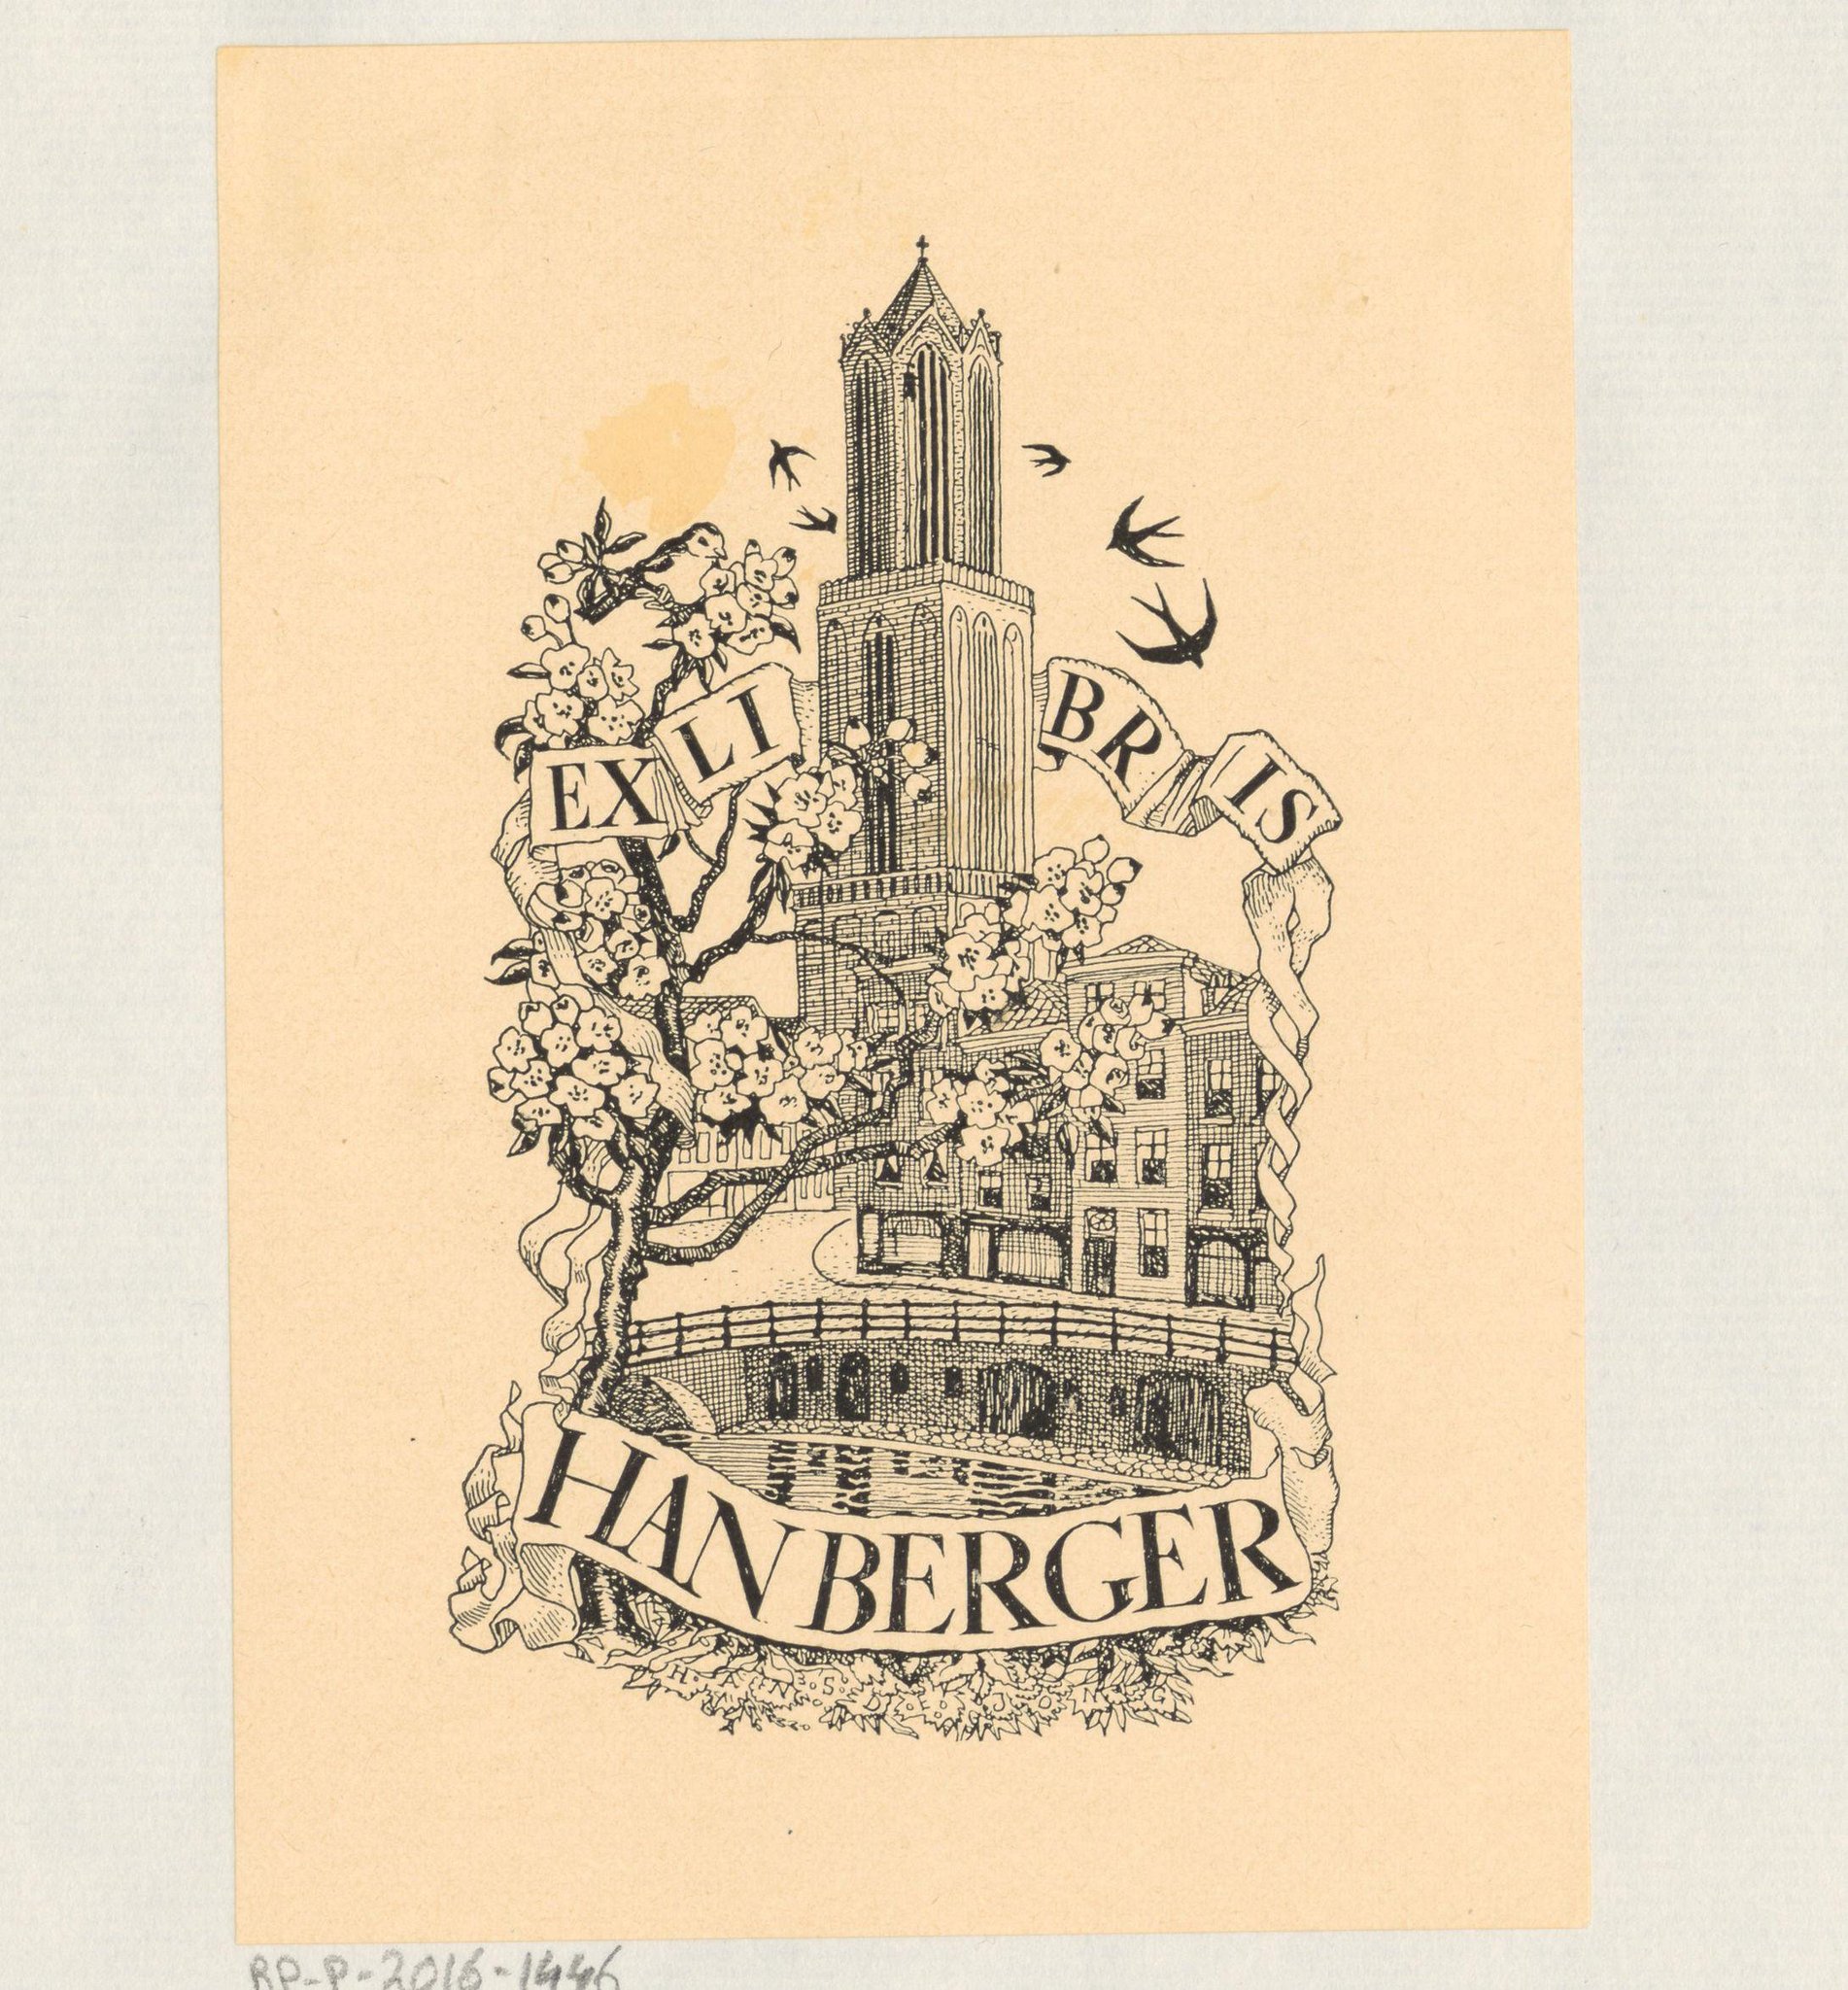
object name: bookplate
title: Ex libris van Han Berger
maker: hendrik de jong (hans)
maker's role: print maker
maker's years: 1914-1957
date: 1944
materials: paper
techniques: printing block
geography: netherlands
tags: canal, church (exterior), utrecht